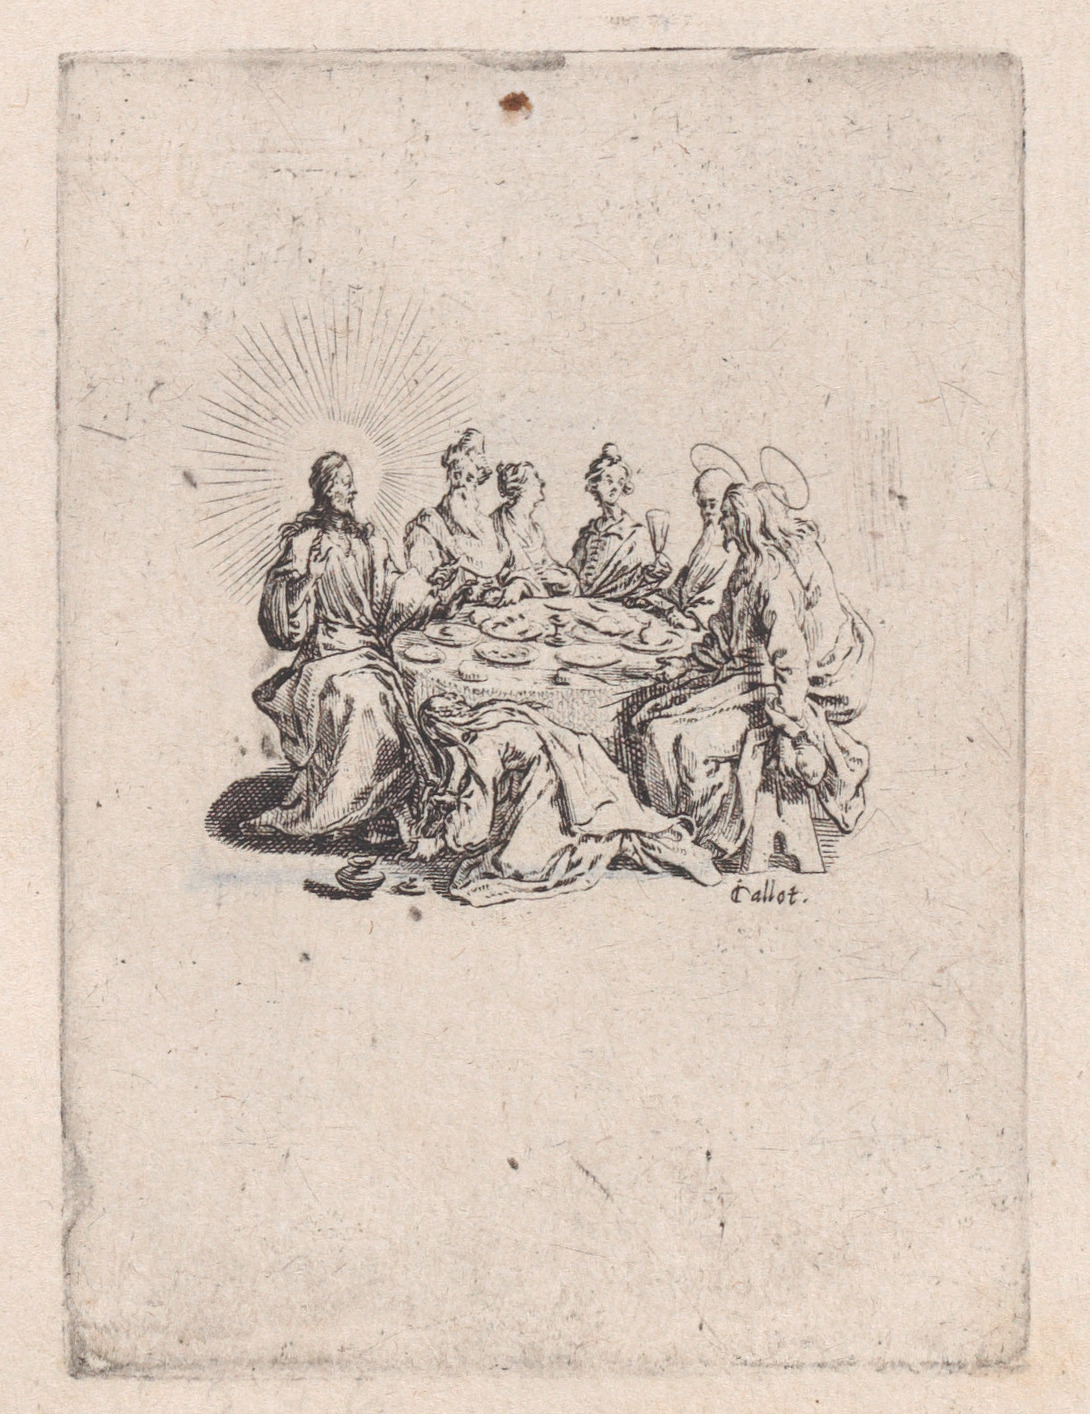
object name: print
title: Le Repas Chez le Pharisien (The Meal at the Home of the Pharisee), from "Les Quatre Banquets" (The Four Feasts)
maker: jacques callot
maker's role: artist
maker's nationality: french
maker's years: 1592-1635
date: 1625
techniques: engraving, etching